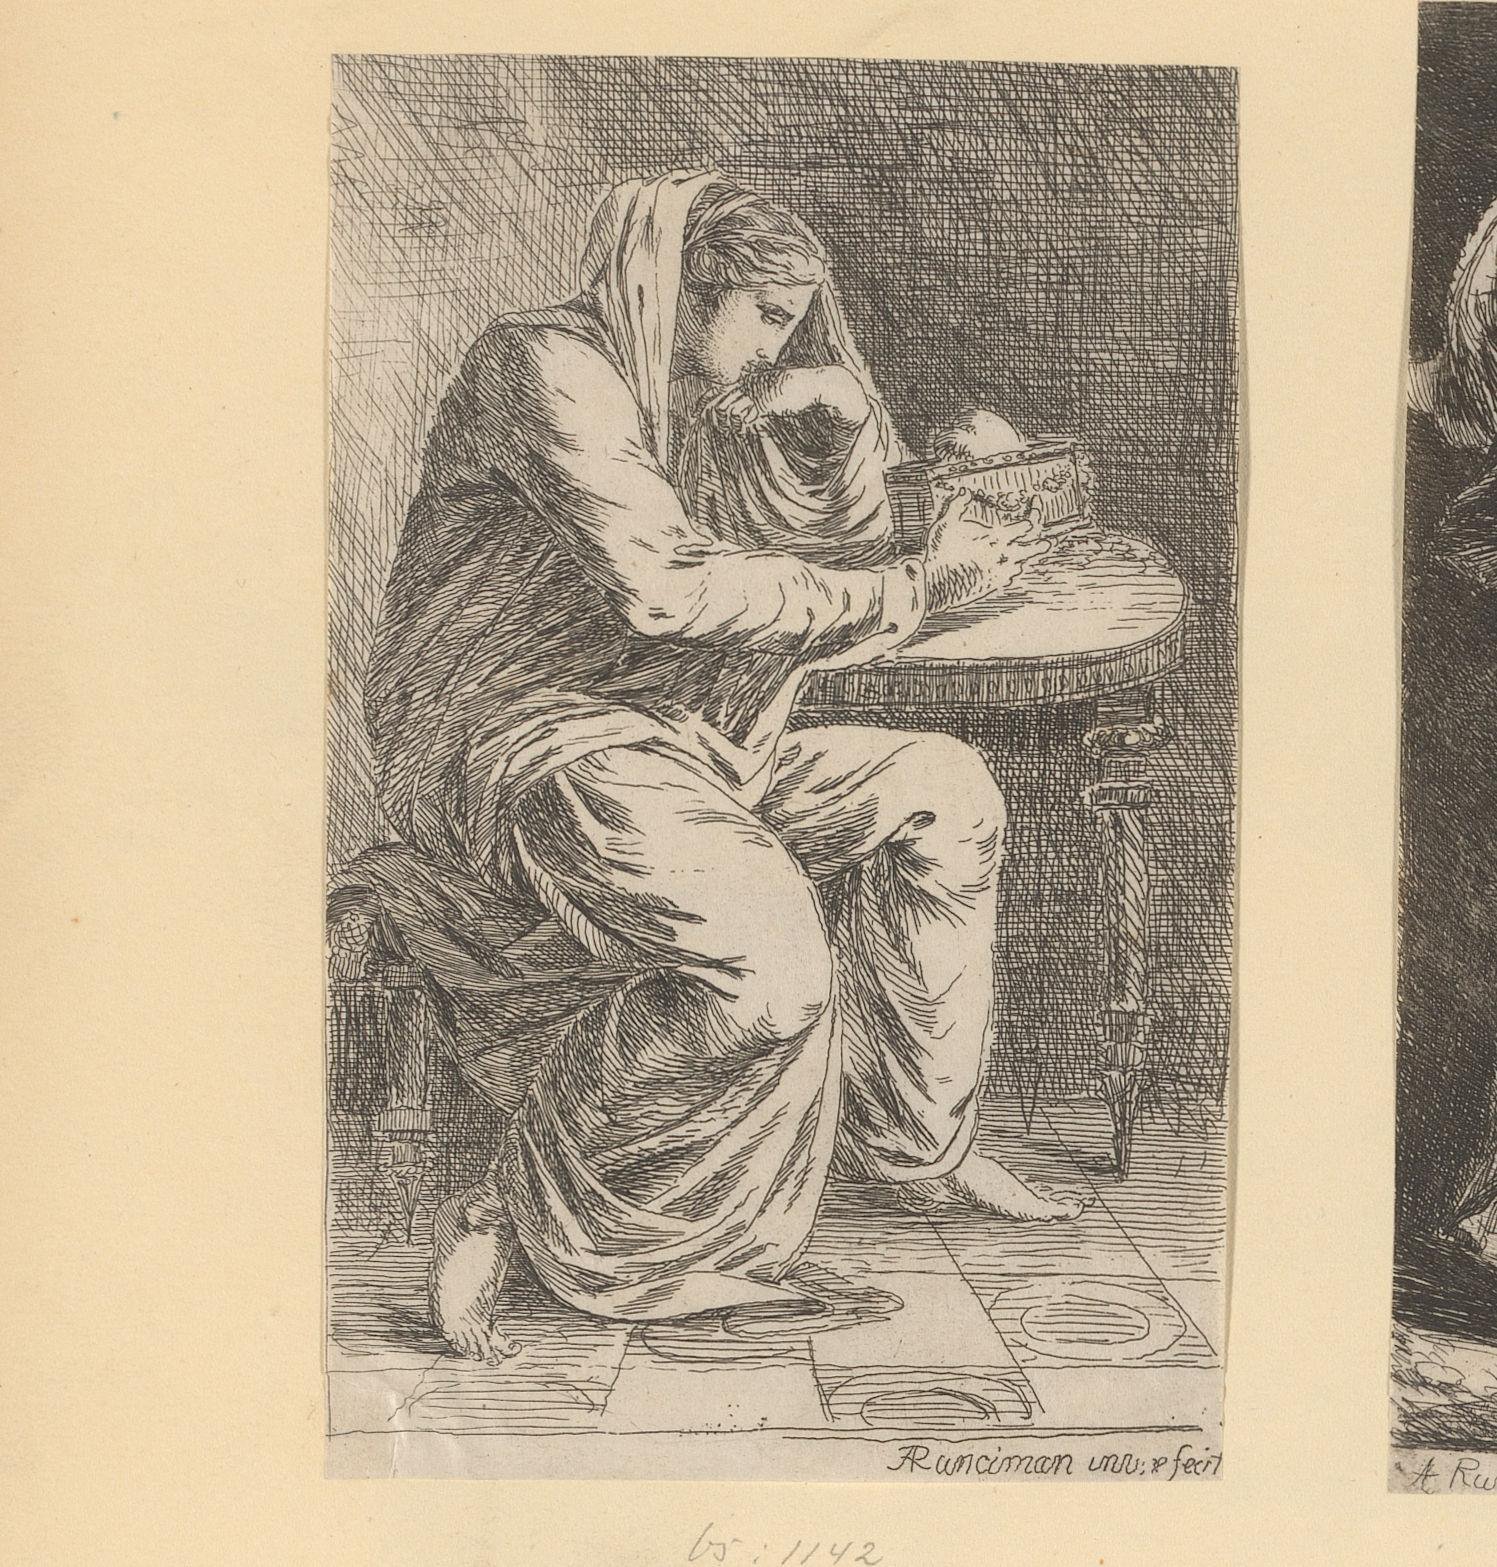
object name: print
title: Sigismunda Weeping over the Heart of Tancred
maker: alexander runciman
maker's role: draughtsman, print maker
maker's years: 1736-1785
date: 1748-1785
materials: paper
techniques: etching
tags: tancred, unsuccessful love affair; seduction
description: Prent maakt mogelijk deel uit van een serie van 200 prenten. Deze serie is onder de titel 'A Collection of two hundred original etchings' voor het eerst uitgegeven door J.M. Greery in 1816.